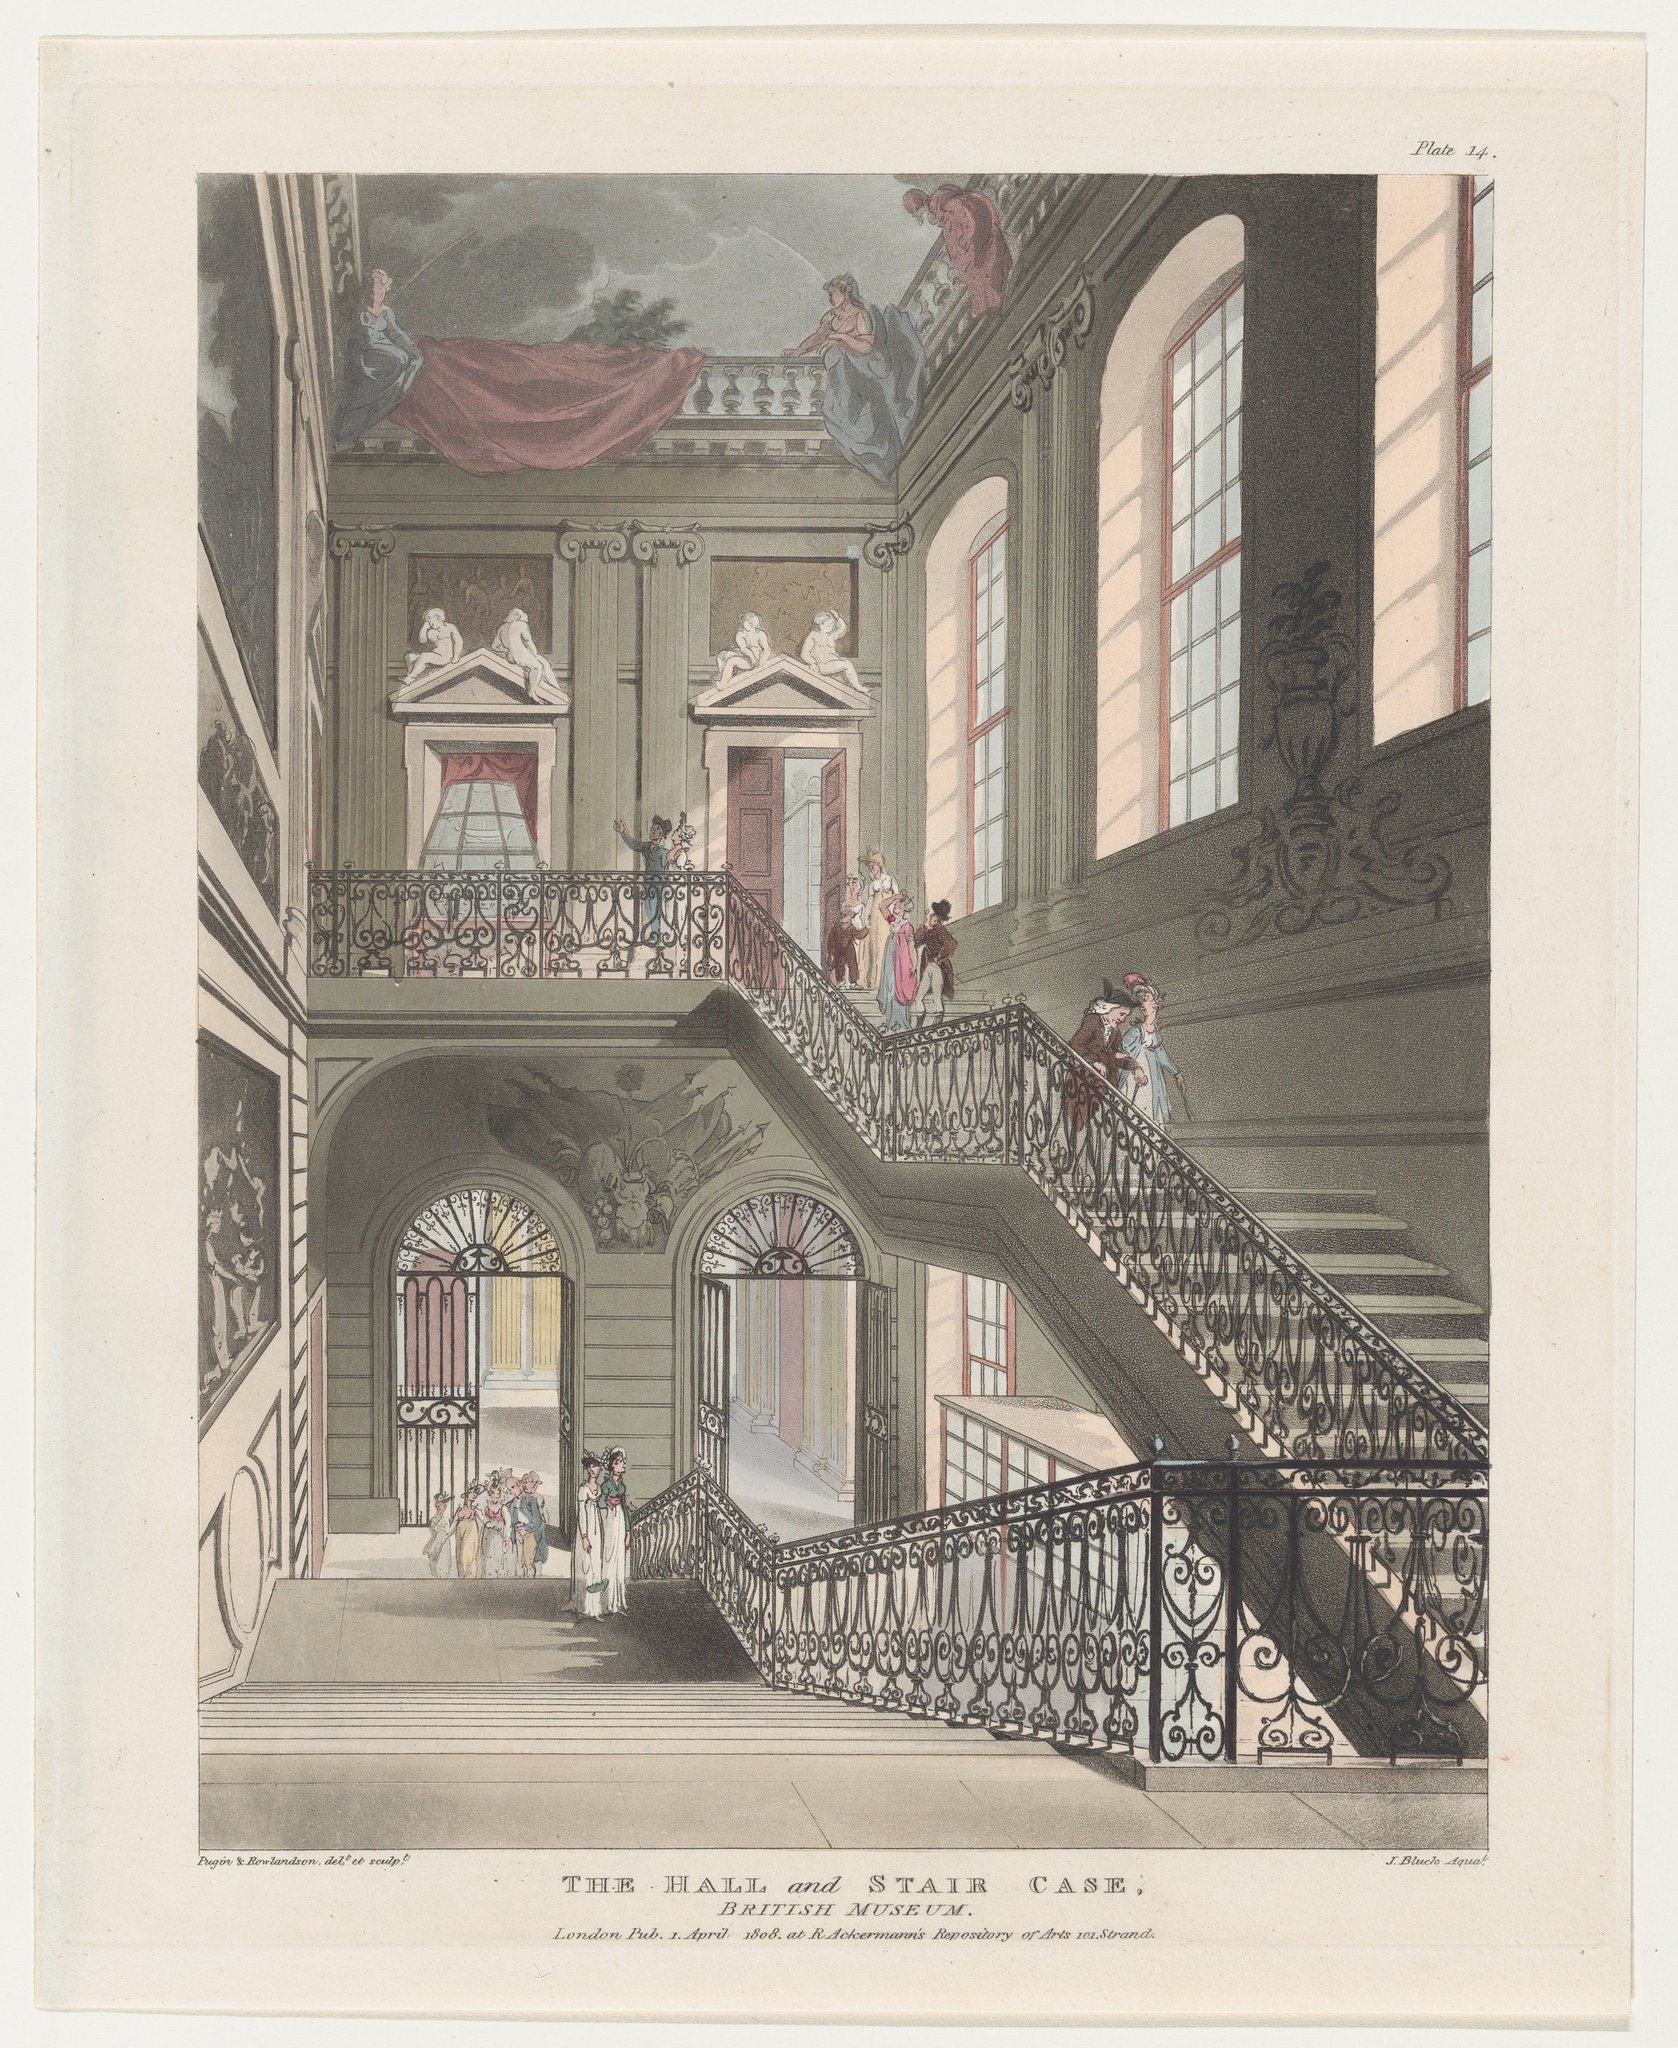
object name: print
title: The Hall and Stair Case, British Museum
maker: thomas rowlandson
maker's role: artist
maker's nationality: british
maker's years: 1757-1827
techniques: aquatint, etching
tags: museums,stairs,interiors